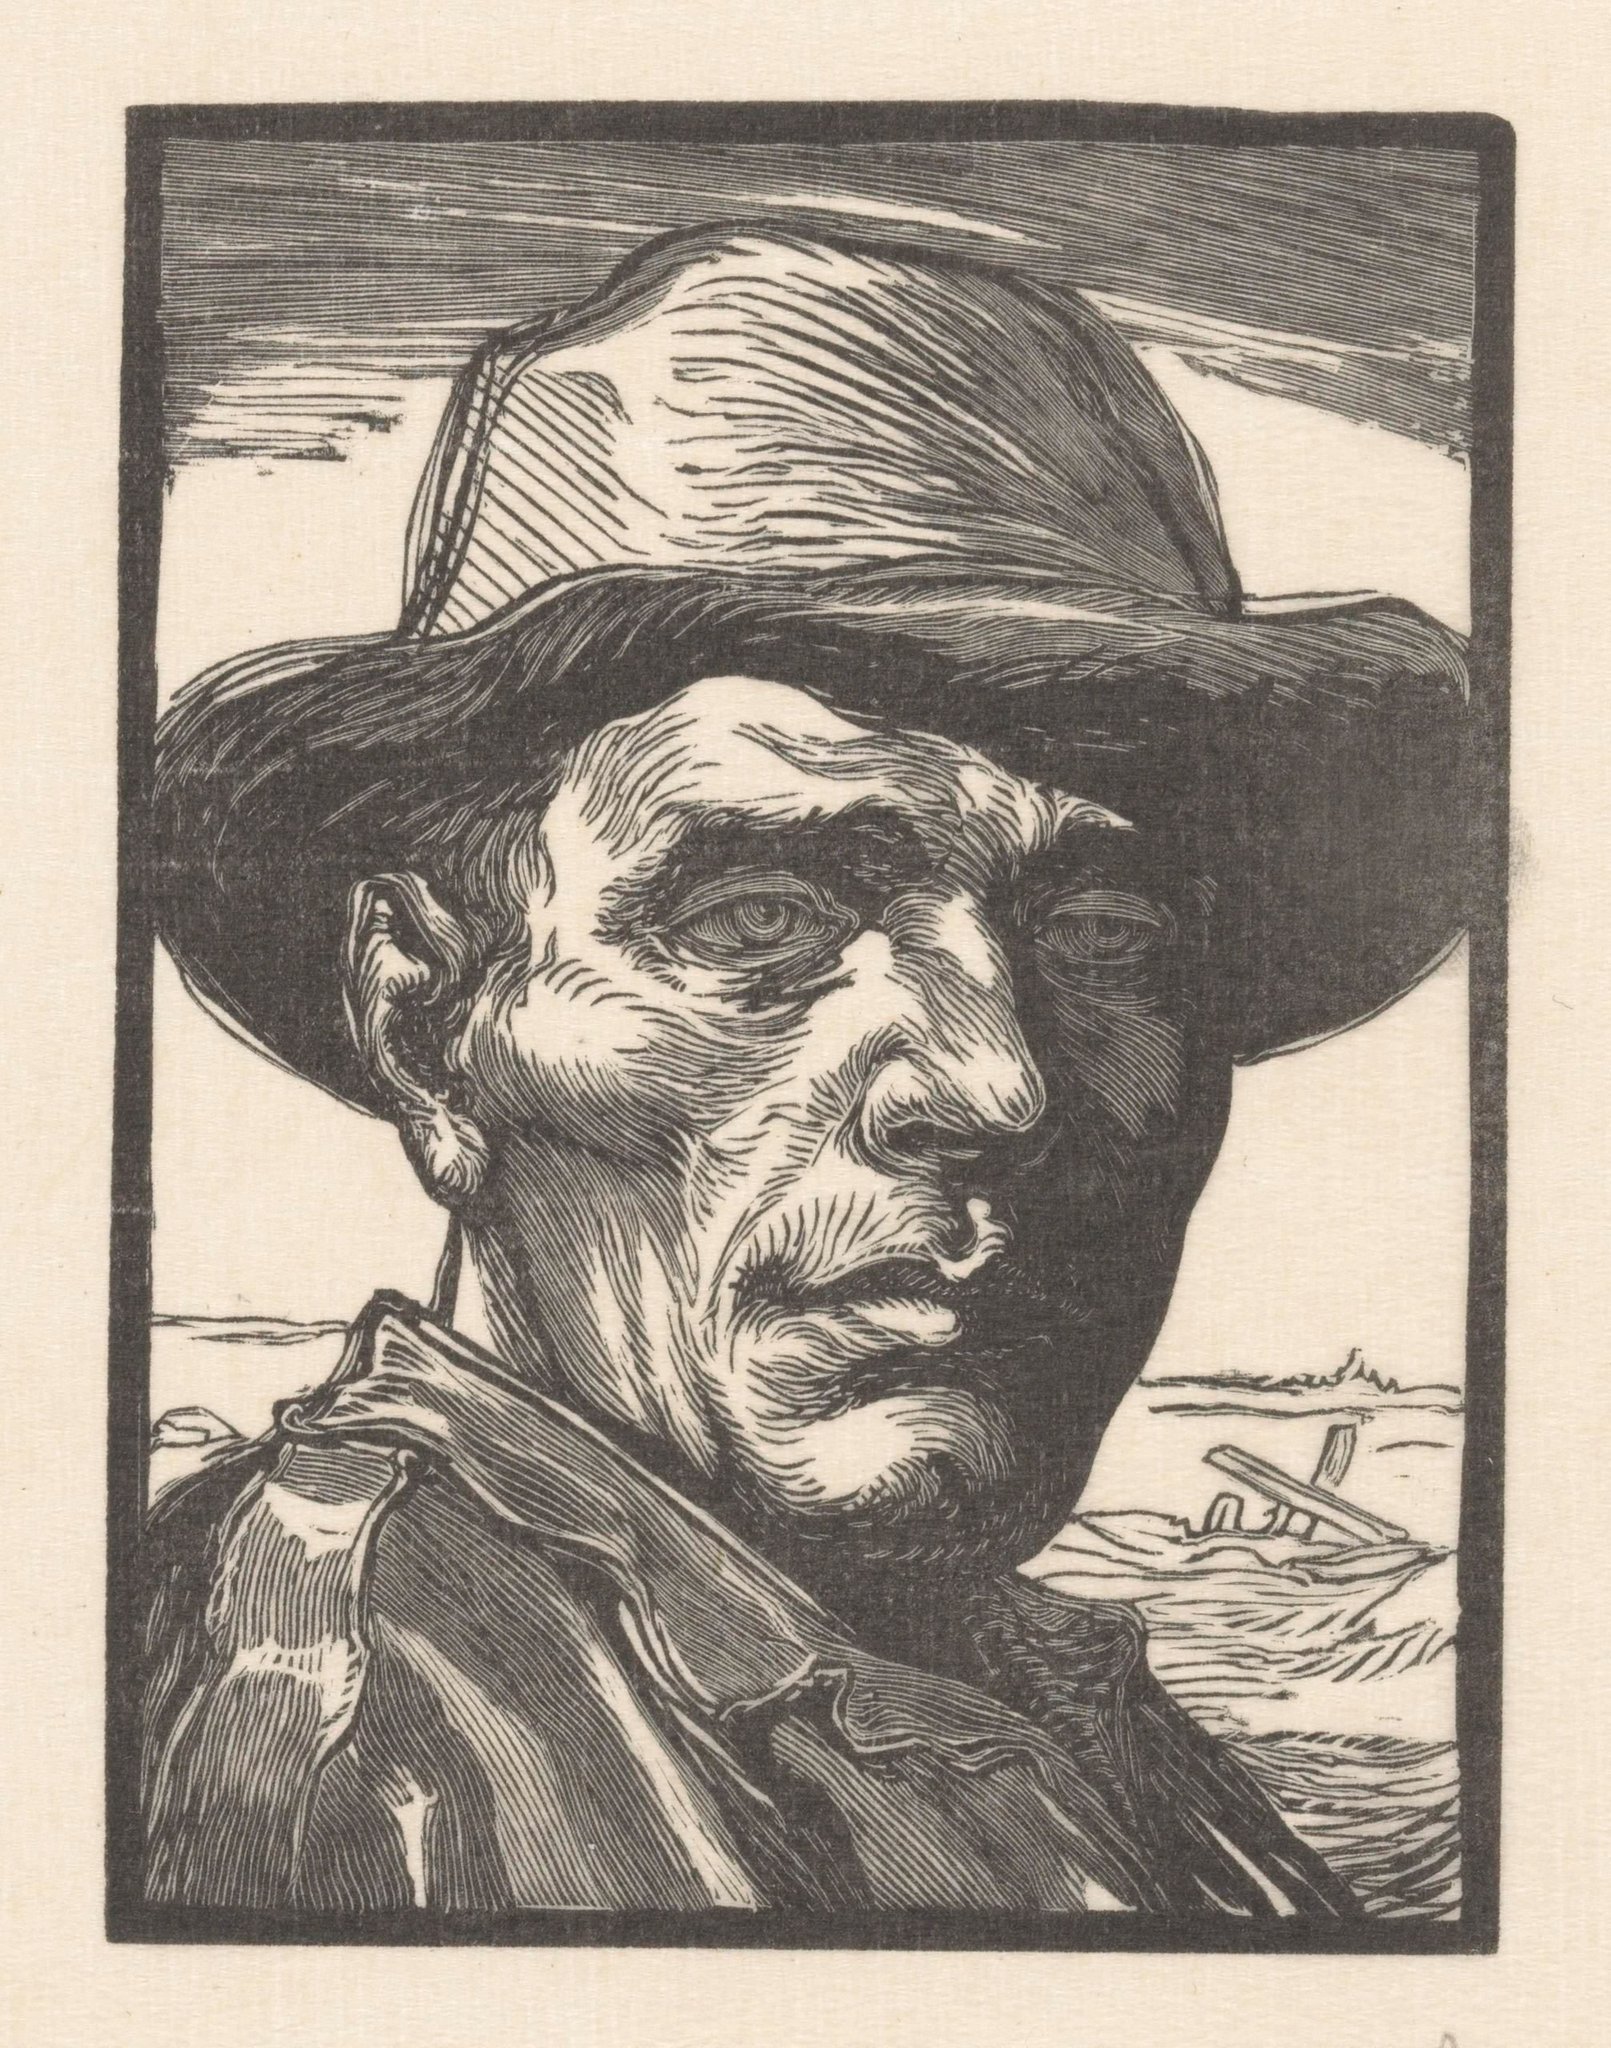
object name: print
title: Portret van een onbekende man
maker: johannes josephus aarts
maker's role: draughtsman, print maker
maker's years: 1871-1934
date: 1881-1931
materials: paper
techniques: woodcut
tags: anonymous historical person portrayed alone, head-gear: hat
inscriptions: collector's mark: Lugt 2228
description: Portret van een man met een hoed. Op de achtergrond een vlak, open landschap.